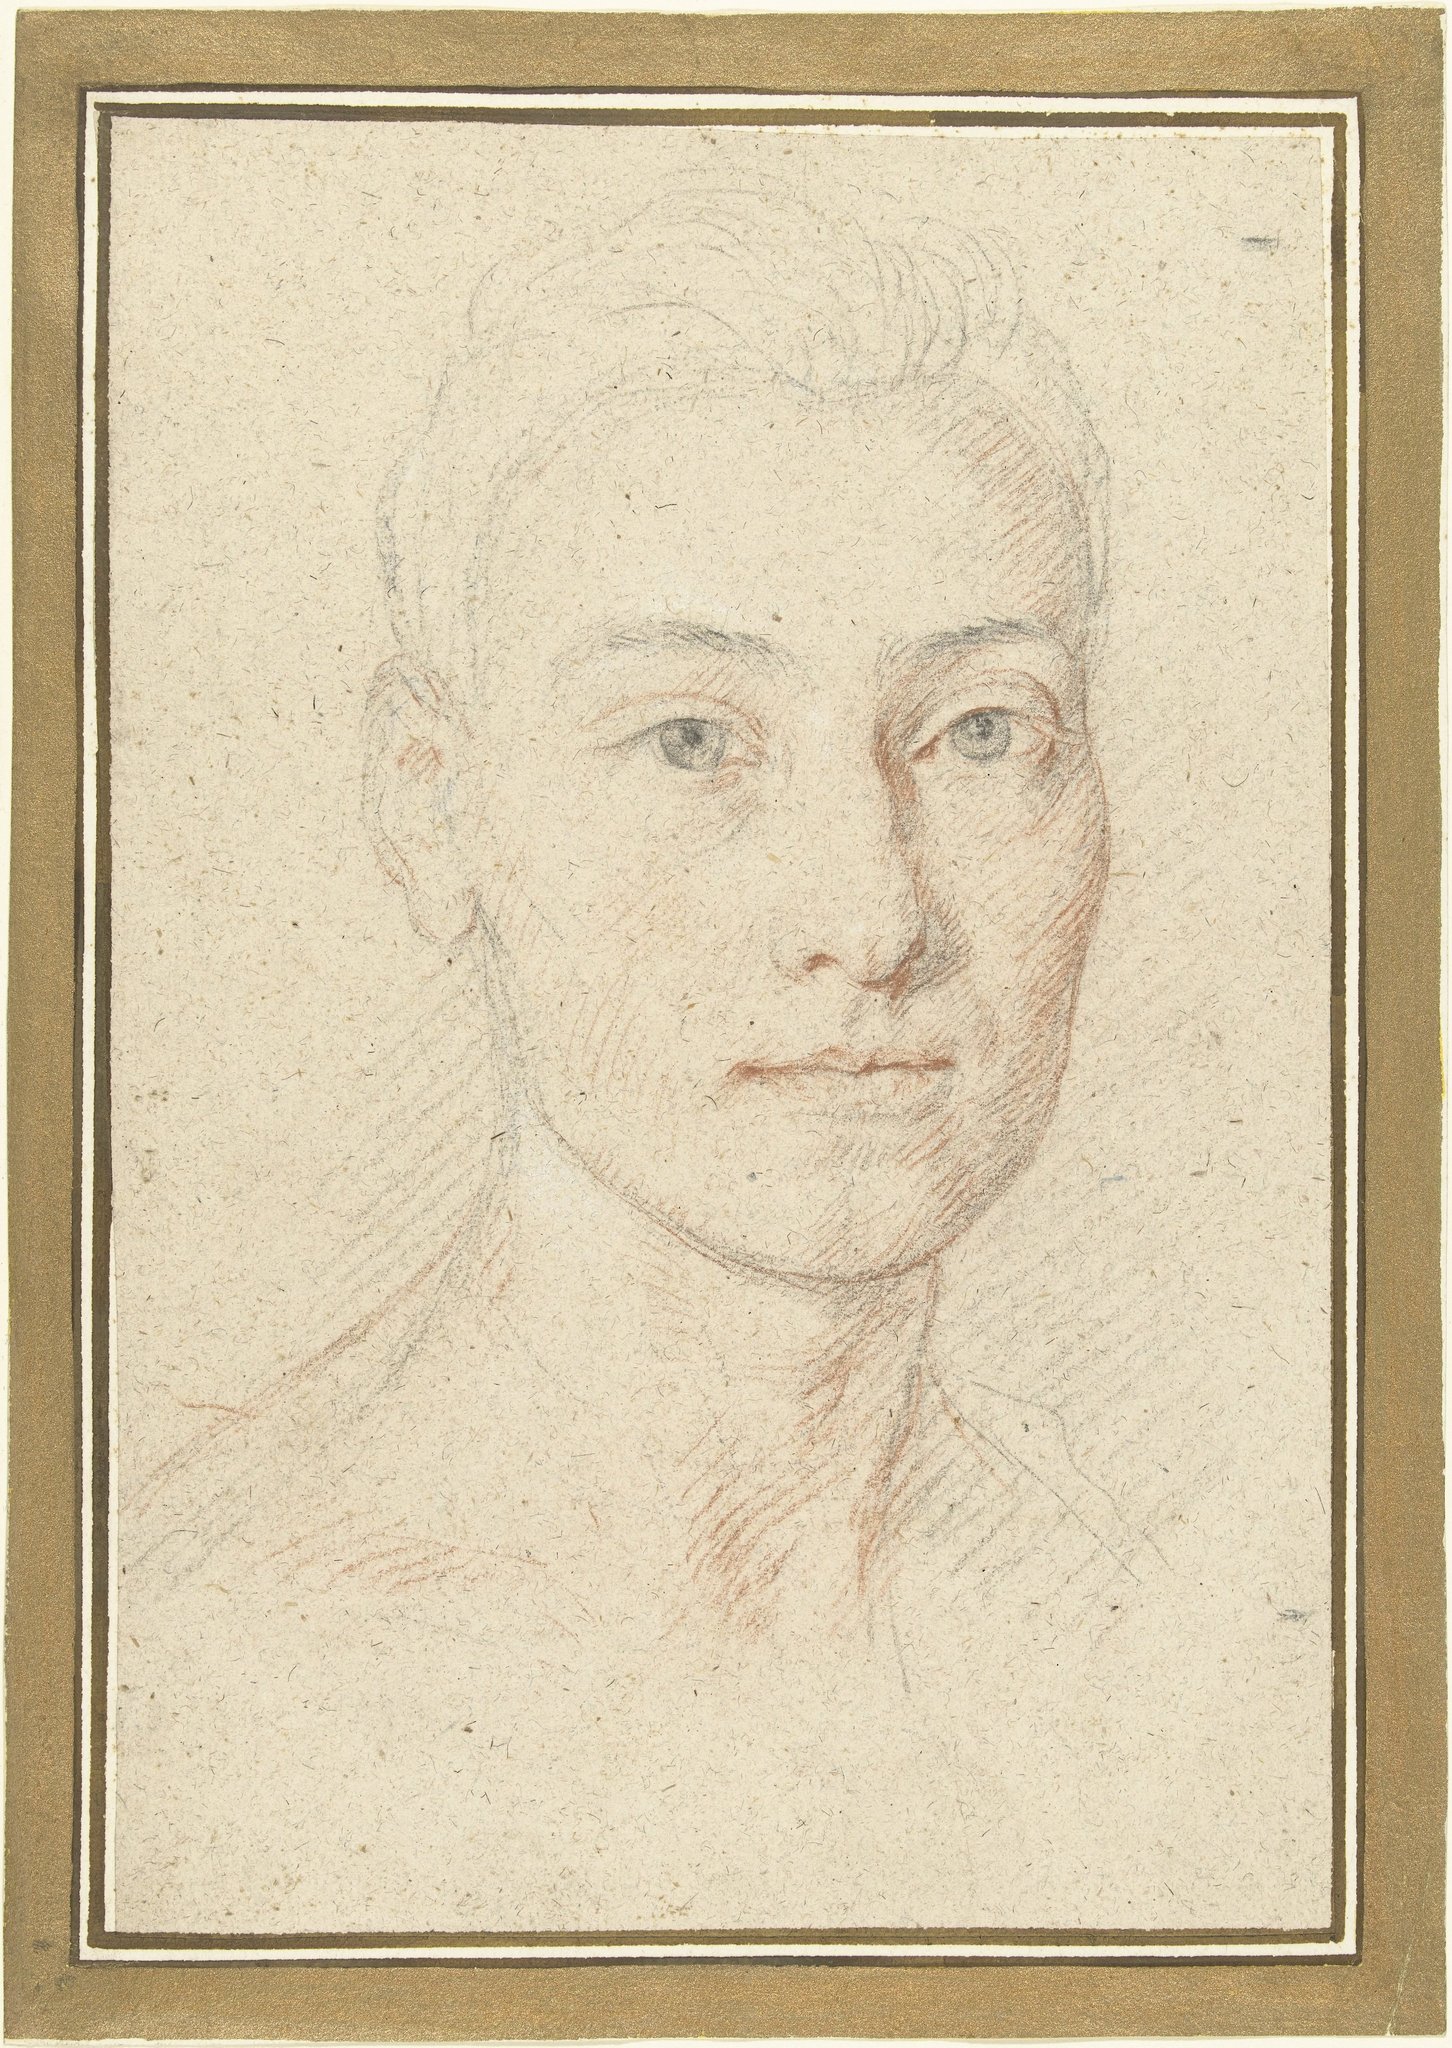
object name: drawing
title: Portret van een onbekende vrouw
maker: johann baptist lampi (i)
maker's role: draughtsman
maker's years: 1751-1830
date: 1761-1830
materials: chalk, paper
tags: anonymous historical person portrayed alone, female sex; woman